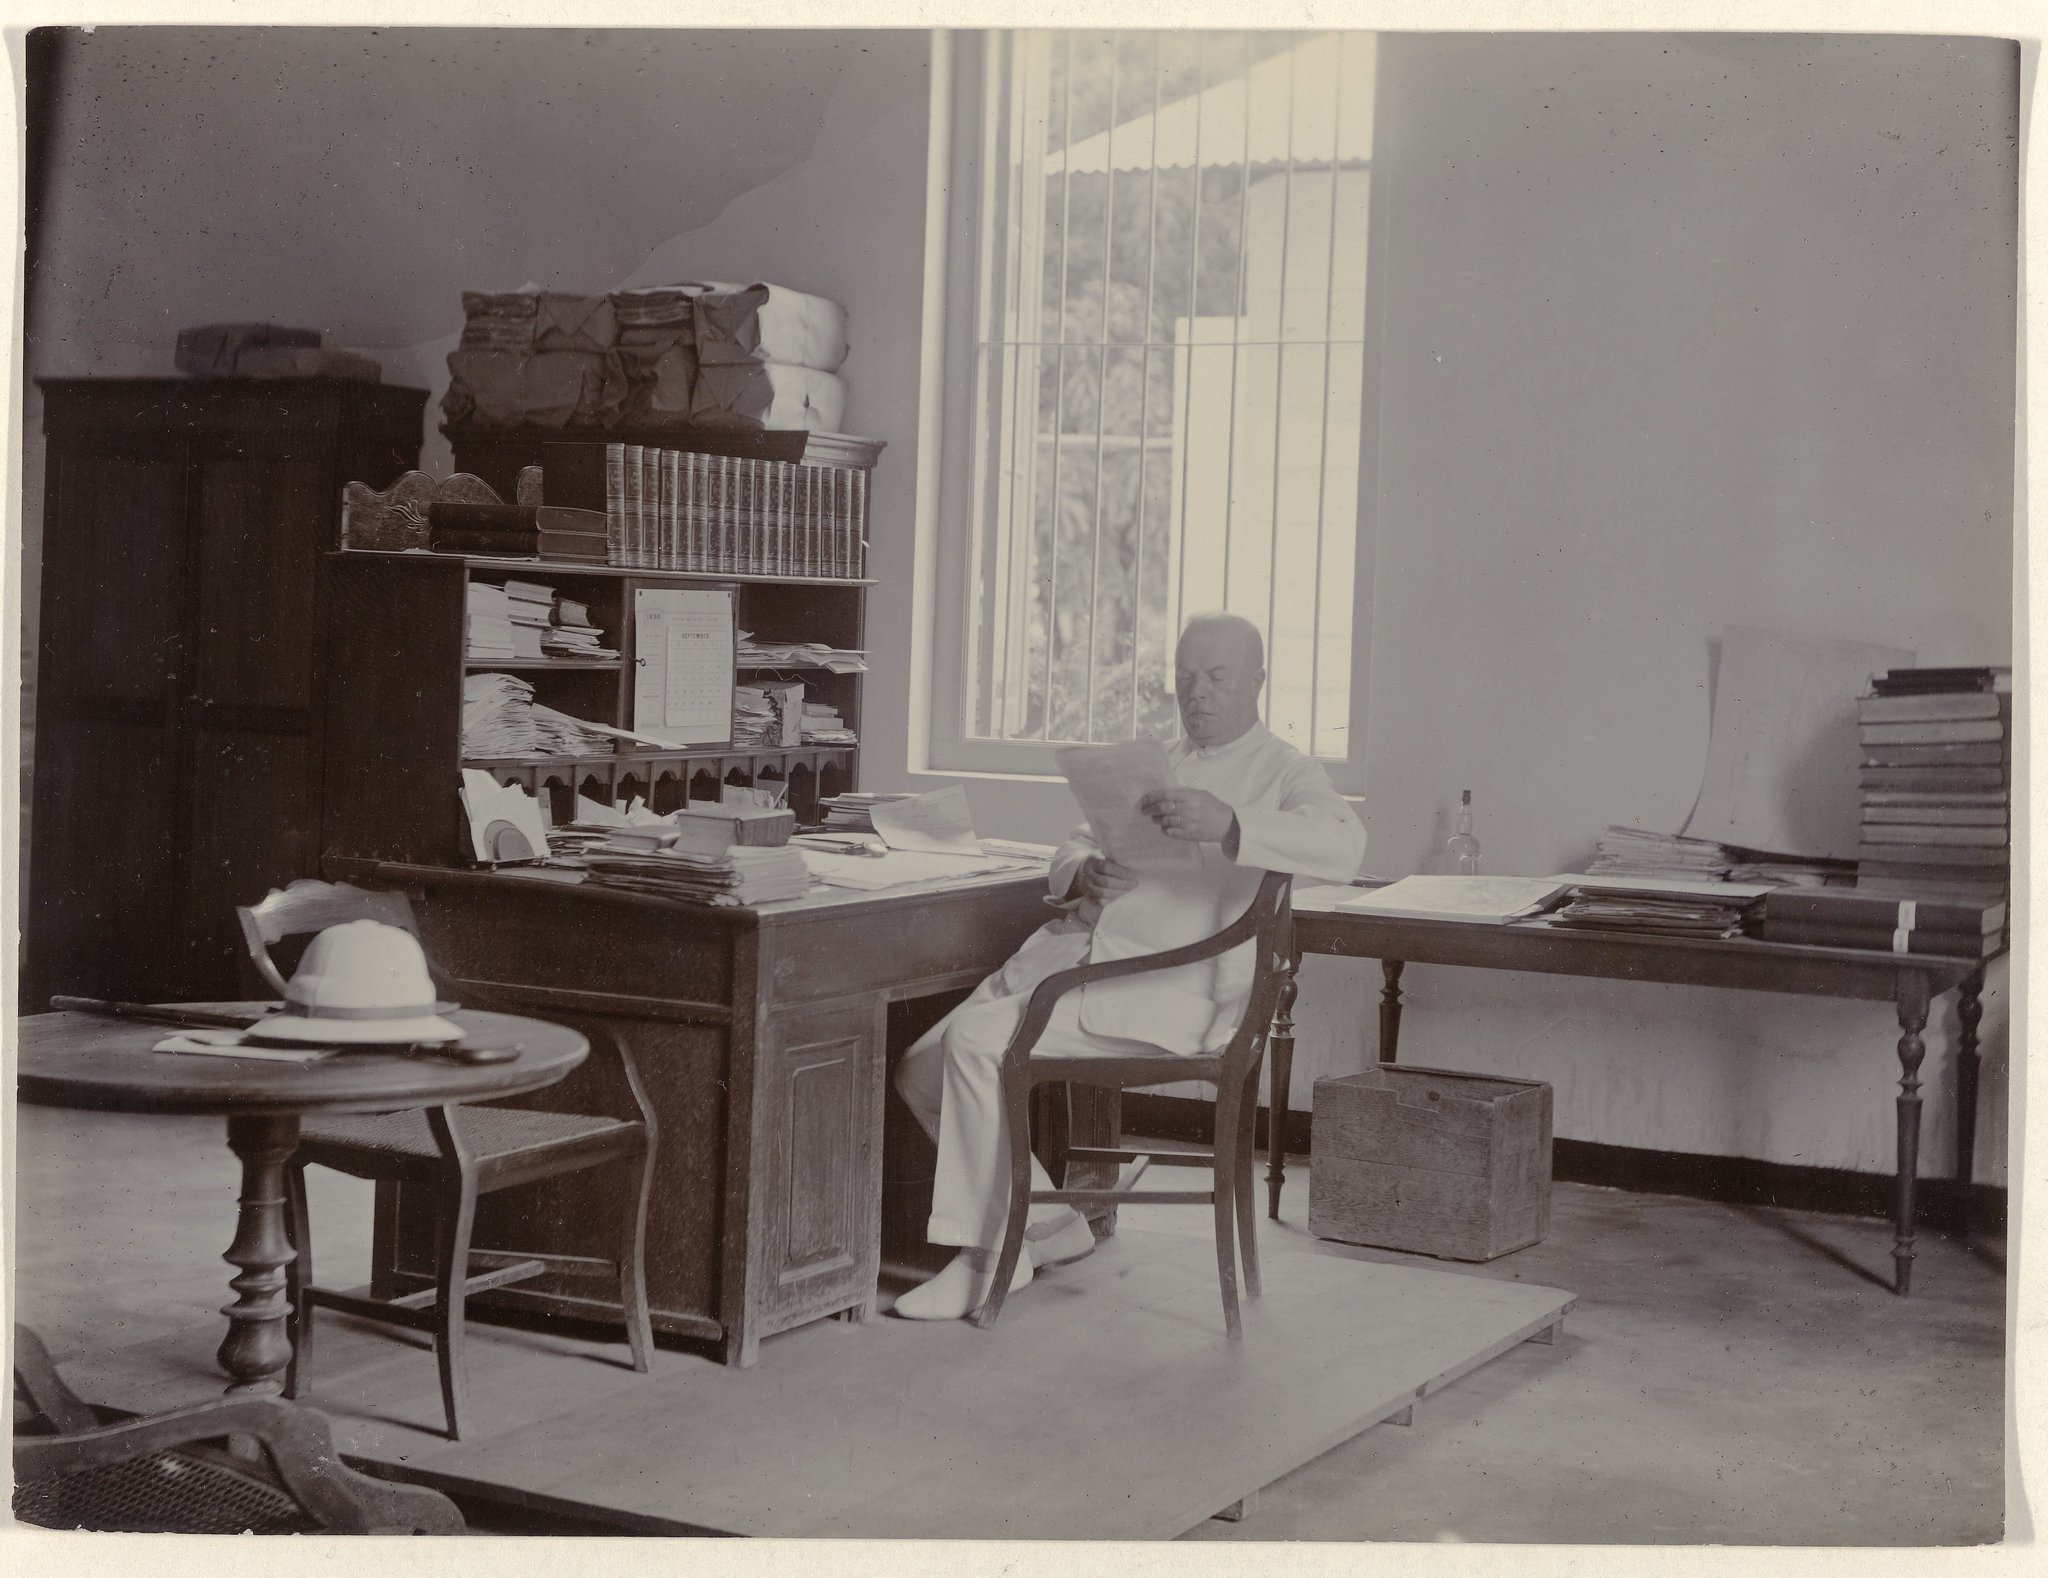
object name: photograph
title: Man achter bureau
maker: Anonymous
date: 1809-1898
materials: photographic support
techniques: collodion silver print, gelatin silver print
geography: medan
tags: dutch east indies, the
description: Een man zittend achter zijn bureau. Waarschijnlijk een lid van de redactie van de Deli Courant te Medan. Op het bureau hangt een kalender met de maand september van het jaar 1898. Onderdeel van een groep van 8 foto's uit september 1898 binnen de groep van 49 losse zwart-wit foto's van verschillend formaat over de uitgeverij en drukkerij van de krant Deli Courant in Medan in de periode 1885-1947.